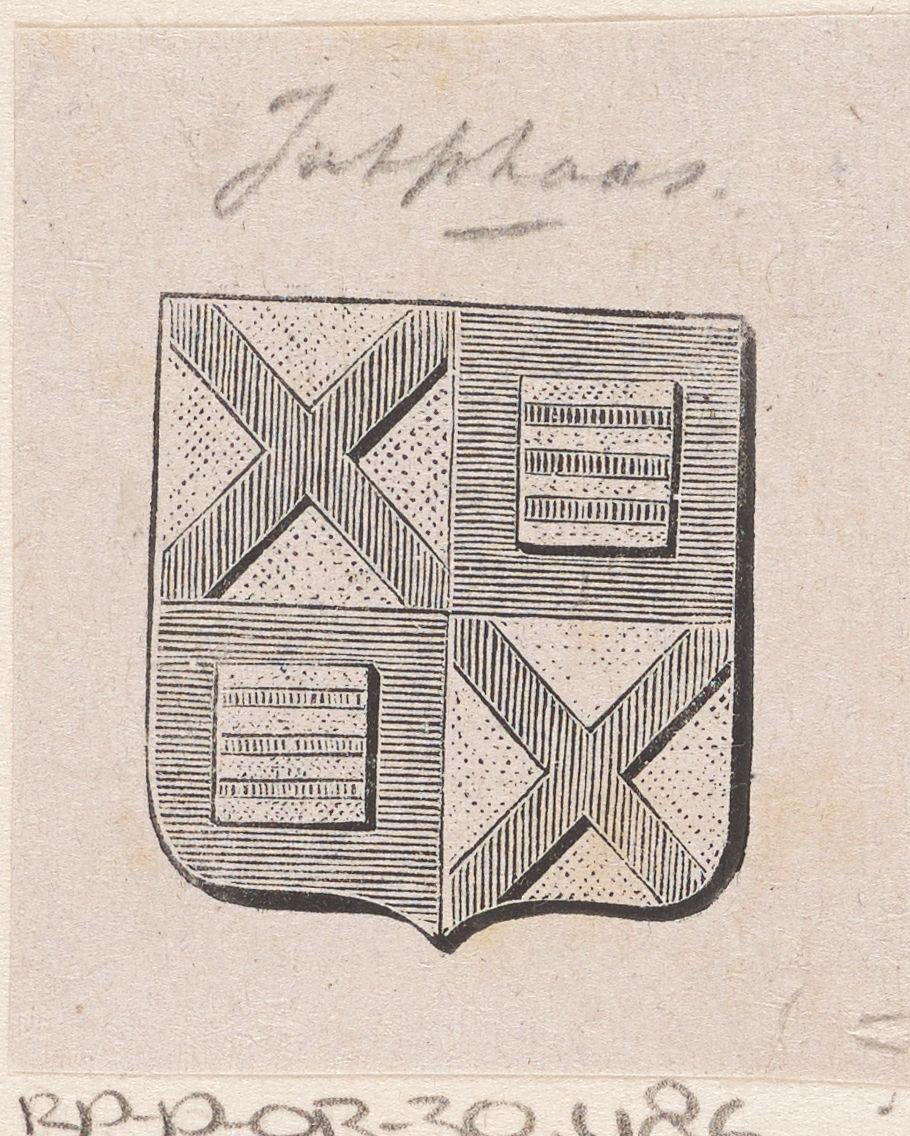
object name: print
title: Vignet met een wapen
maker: isaac weissenbruch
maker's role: print maker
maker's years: 1826-1912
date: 1836-1912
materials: paper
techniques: engraving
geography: netherlands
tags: coat of arms (as symbol of the state, etc.), vignette